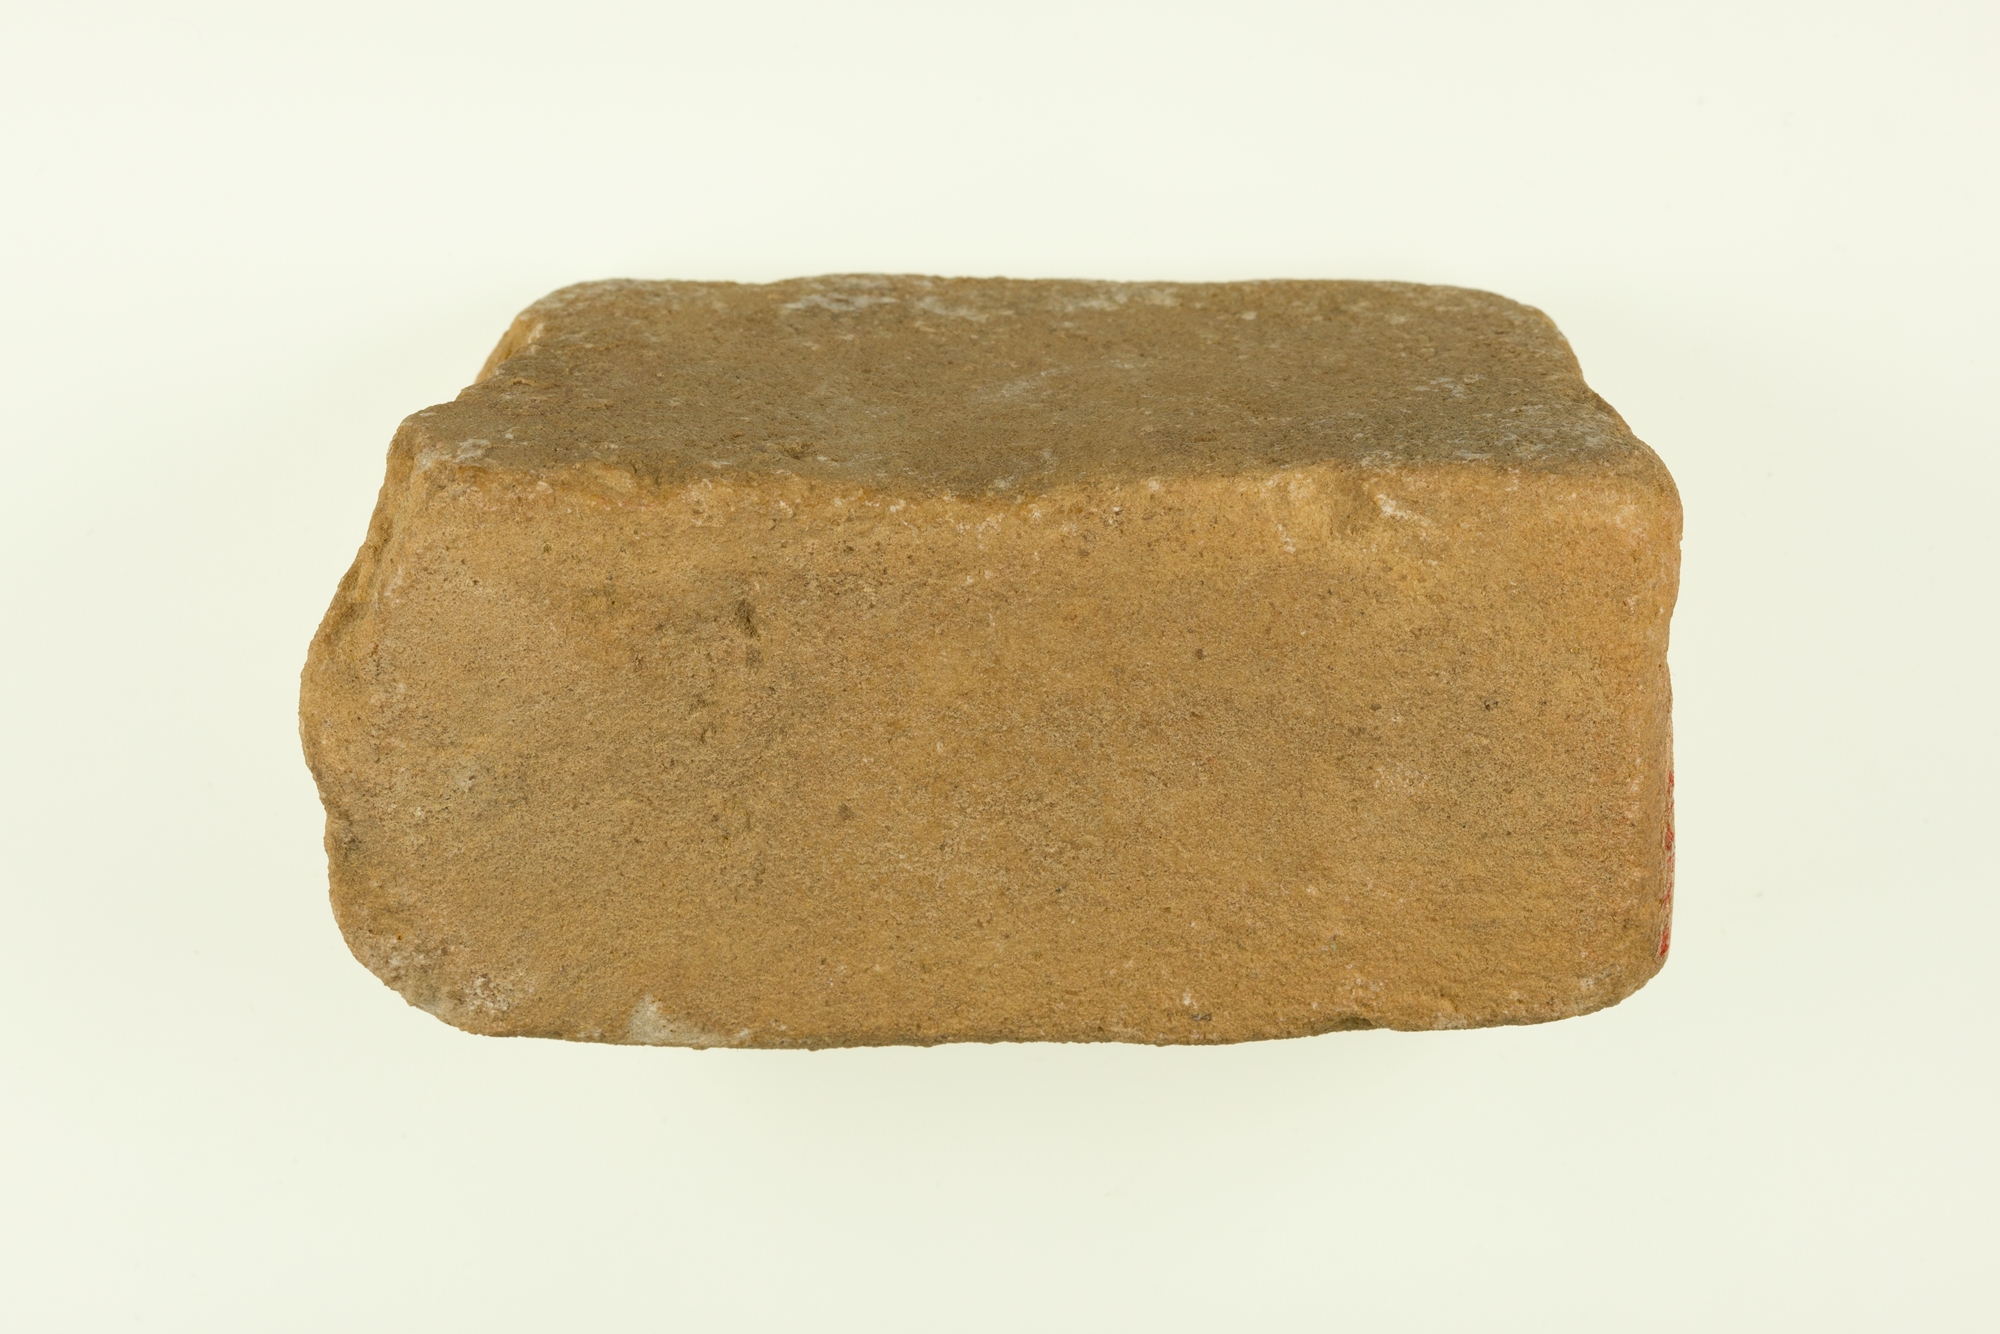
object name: grinding stone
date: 1295-1070 BCE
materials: granite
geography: egypt